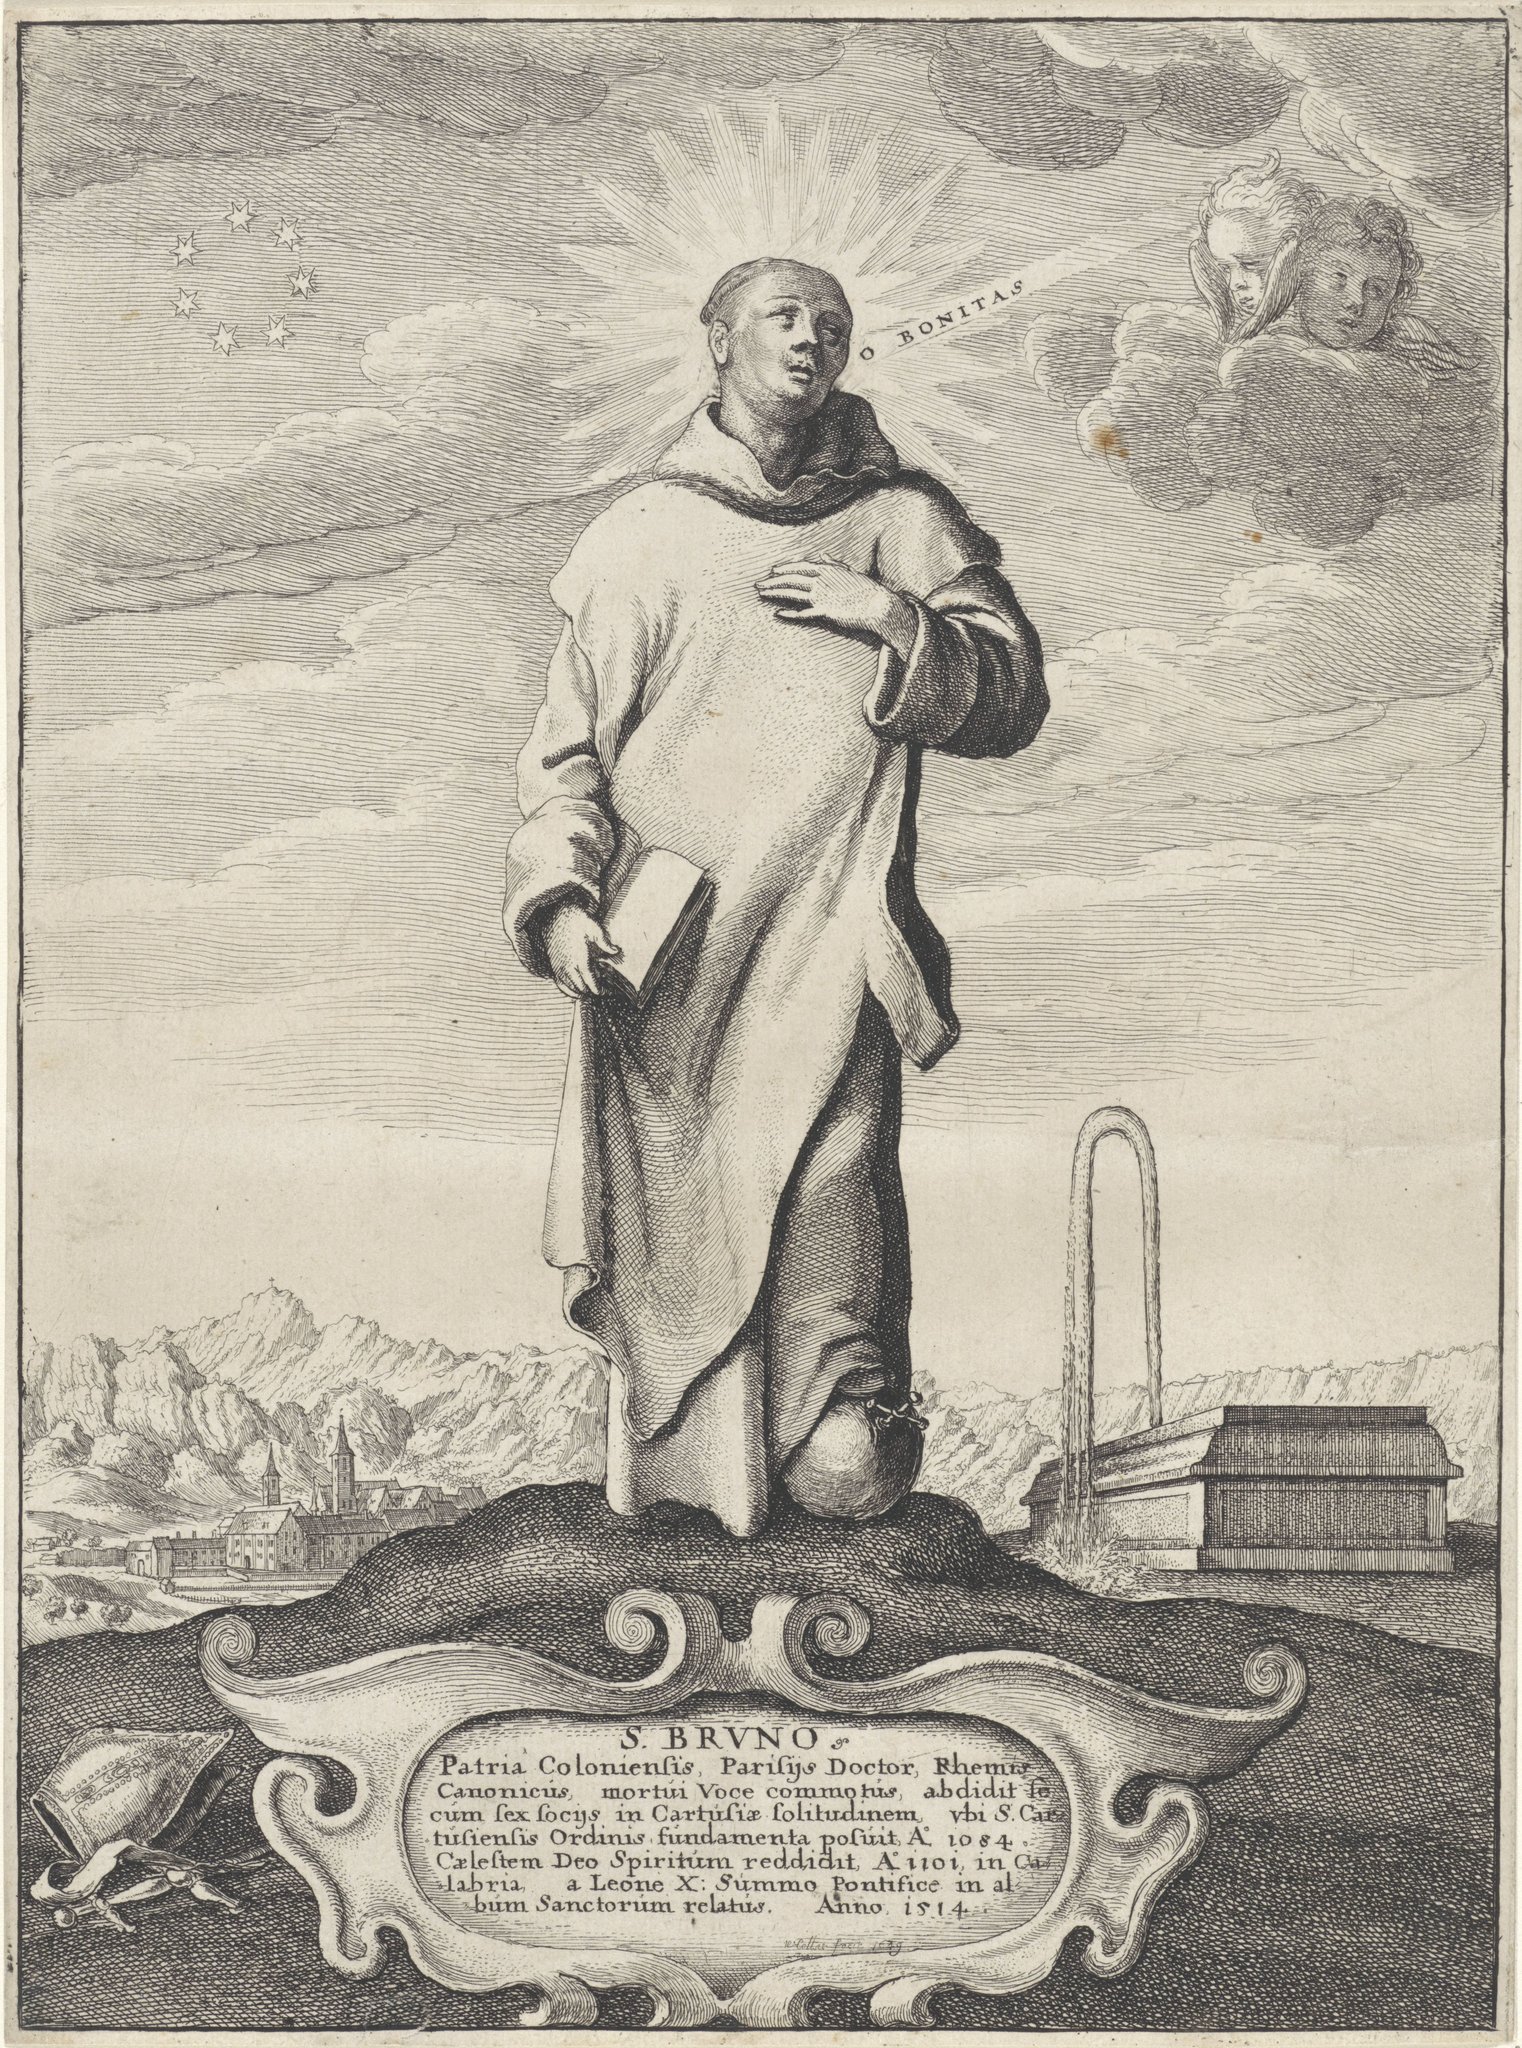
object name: print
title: H. Bruno van Keulen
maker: wenceslaus hollar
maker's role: draughtsman, print maker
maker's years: 1607-1677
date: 1649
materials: paper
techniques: etching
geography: antwerp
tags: the founder of the order of the carthusians, bruno; possible attributes: cross, finger at lips, lily, mitre at his feet, olive-branch, ray of light, skull, (seven) star(s), abbey, monastery, convent ~ roman catholic church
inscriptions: collector's mark: Lugt 2228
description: De heilige Bruno van Keulen, staand op een heuveltje met een boek in zijn hand. Zijn blik is gericht op twee cherubijnen op een wolk, zijn voet steunt op een rijksappel. In de verte ligt het door hem gestichte Grande Chartreuse, het moederklooster van de orde van de Kartuizers.